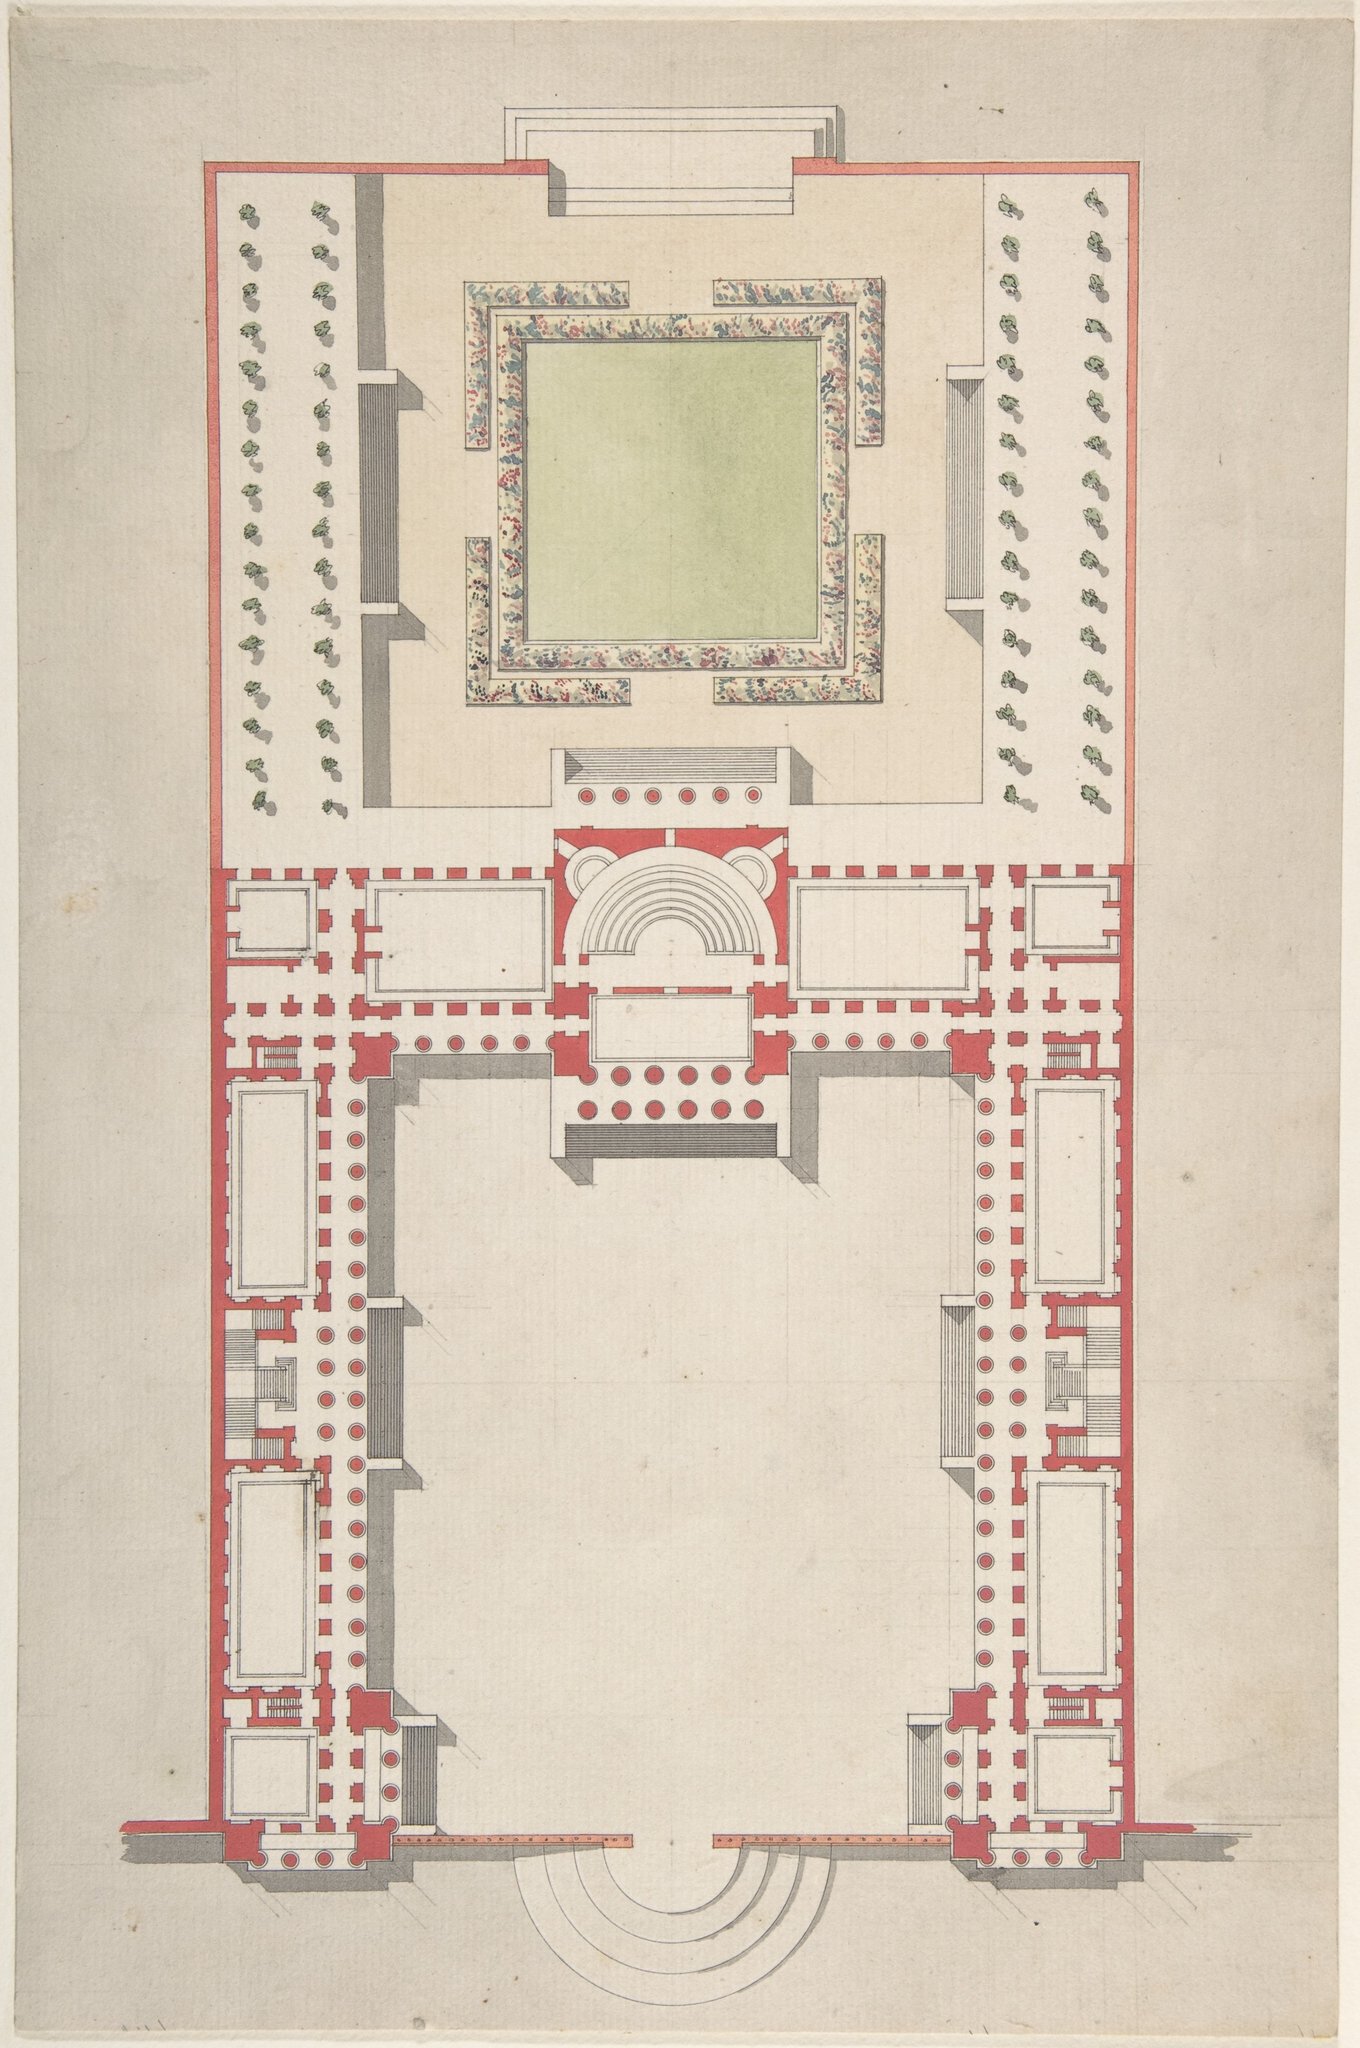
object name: drawing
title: Architectural Ground Plan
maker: paul guillaume lemoine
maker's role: artist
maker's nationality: french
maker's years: 1755-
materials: graphite, ink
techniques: brush, pen, drawing, wash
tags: architecture,buildings